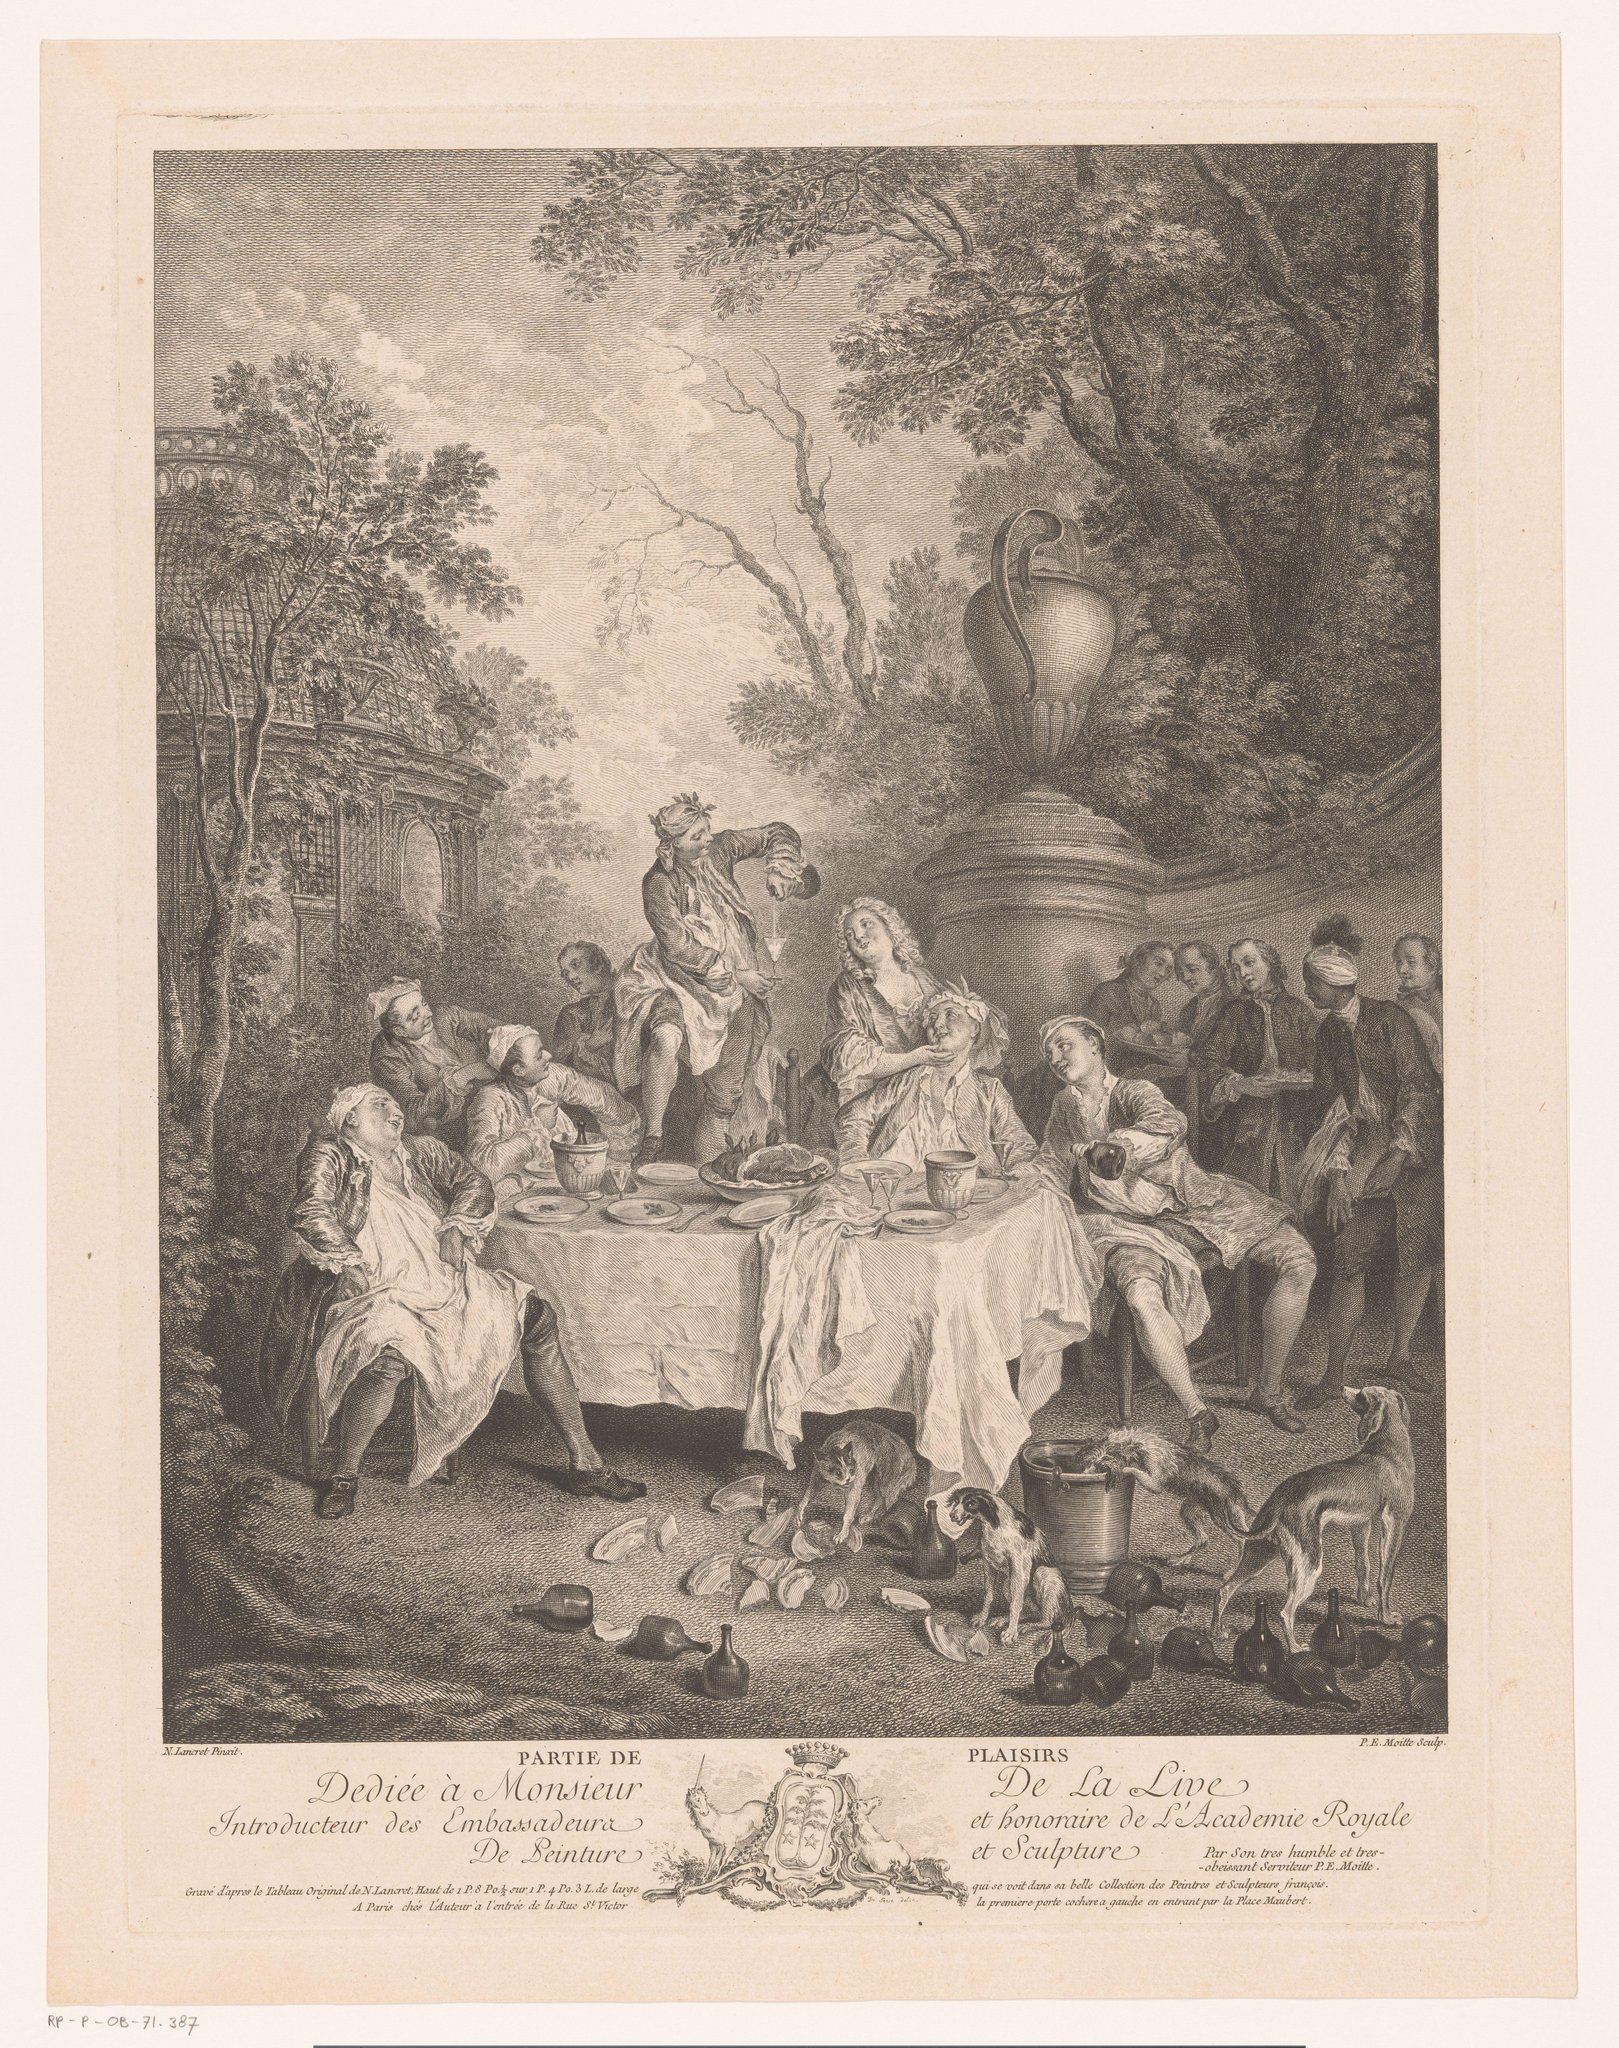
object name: print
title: Partie de Plaisirs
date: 1732-1780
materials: paper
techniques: engraving, etching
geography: paris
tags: garden, celebration meal, feast, banquet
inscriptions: collector's mark: Lugt 2228